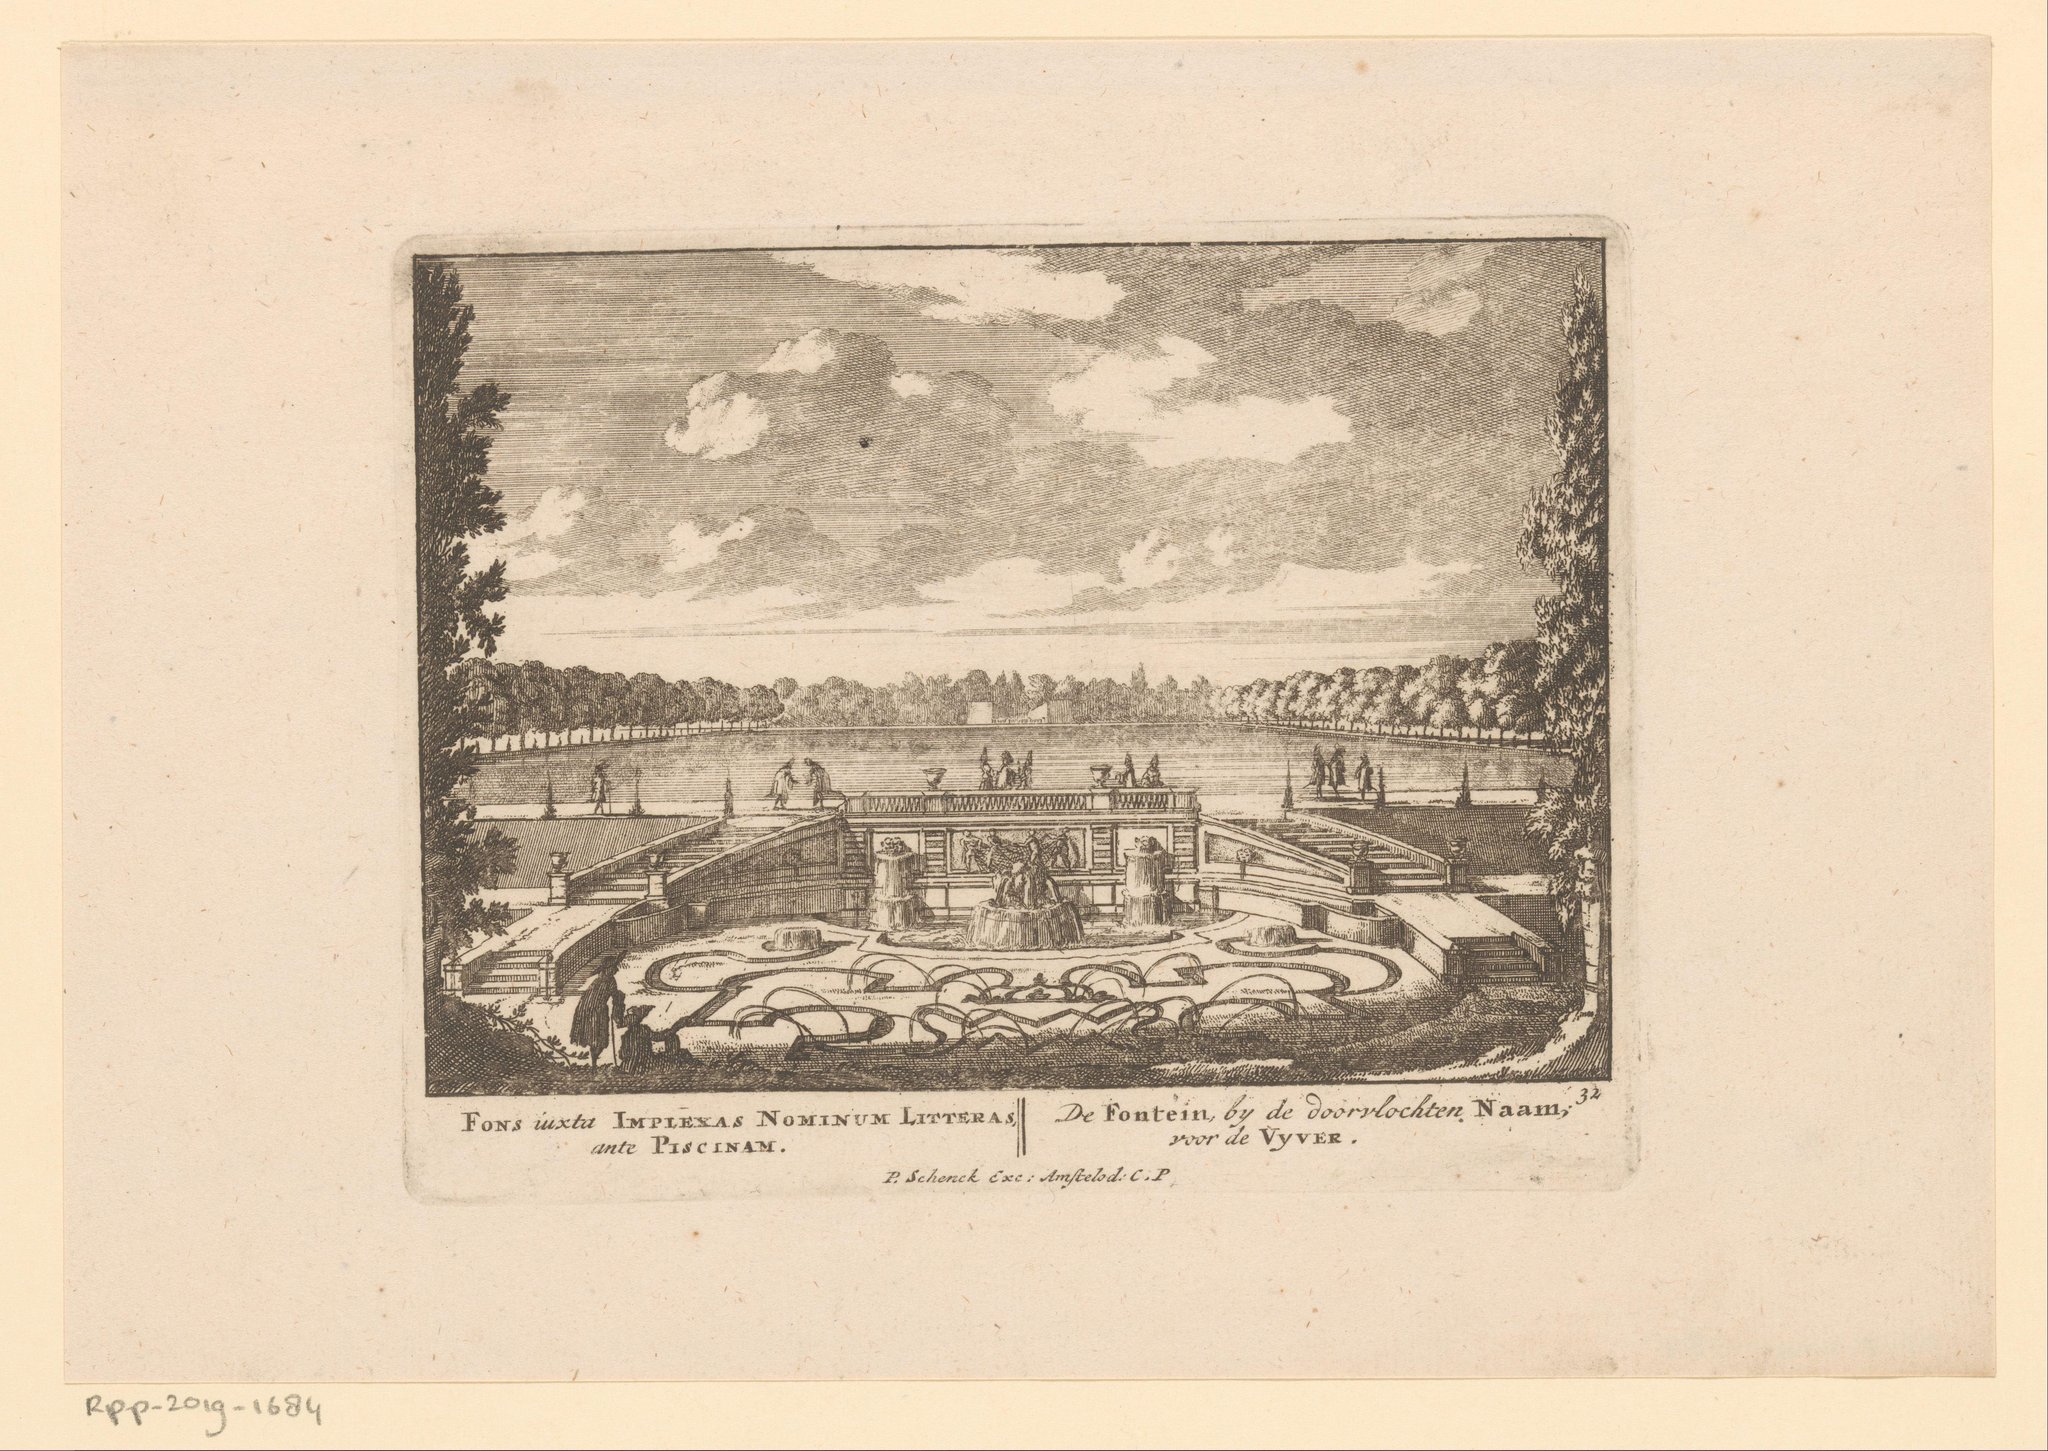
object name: print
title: Viervoudig schouwspel van wonderen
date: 1700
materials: paper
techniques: etching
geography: amsterdam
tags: garden, garden fountain, palace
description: Andere staat ook gebruikt in: Call, Jan van. Admirandorum Quadruplex Spectaculum. Amsterdam: Pieter Schenk (I), [1700].* * De titelprent, opdracht en het portret van Frederik van Saksen zijn gegraveerd door Pieter Schenk (I). De overige prenten uit deze serie zijn, zoals aangegeven op de titelprent, van de hand van Jan van Call (I).